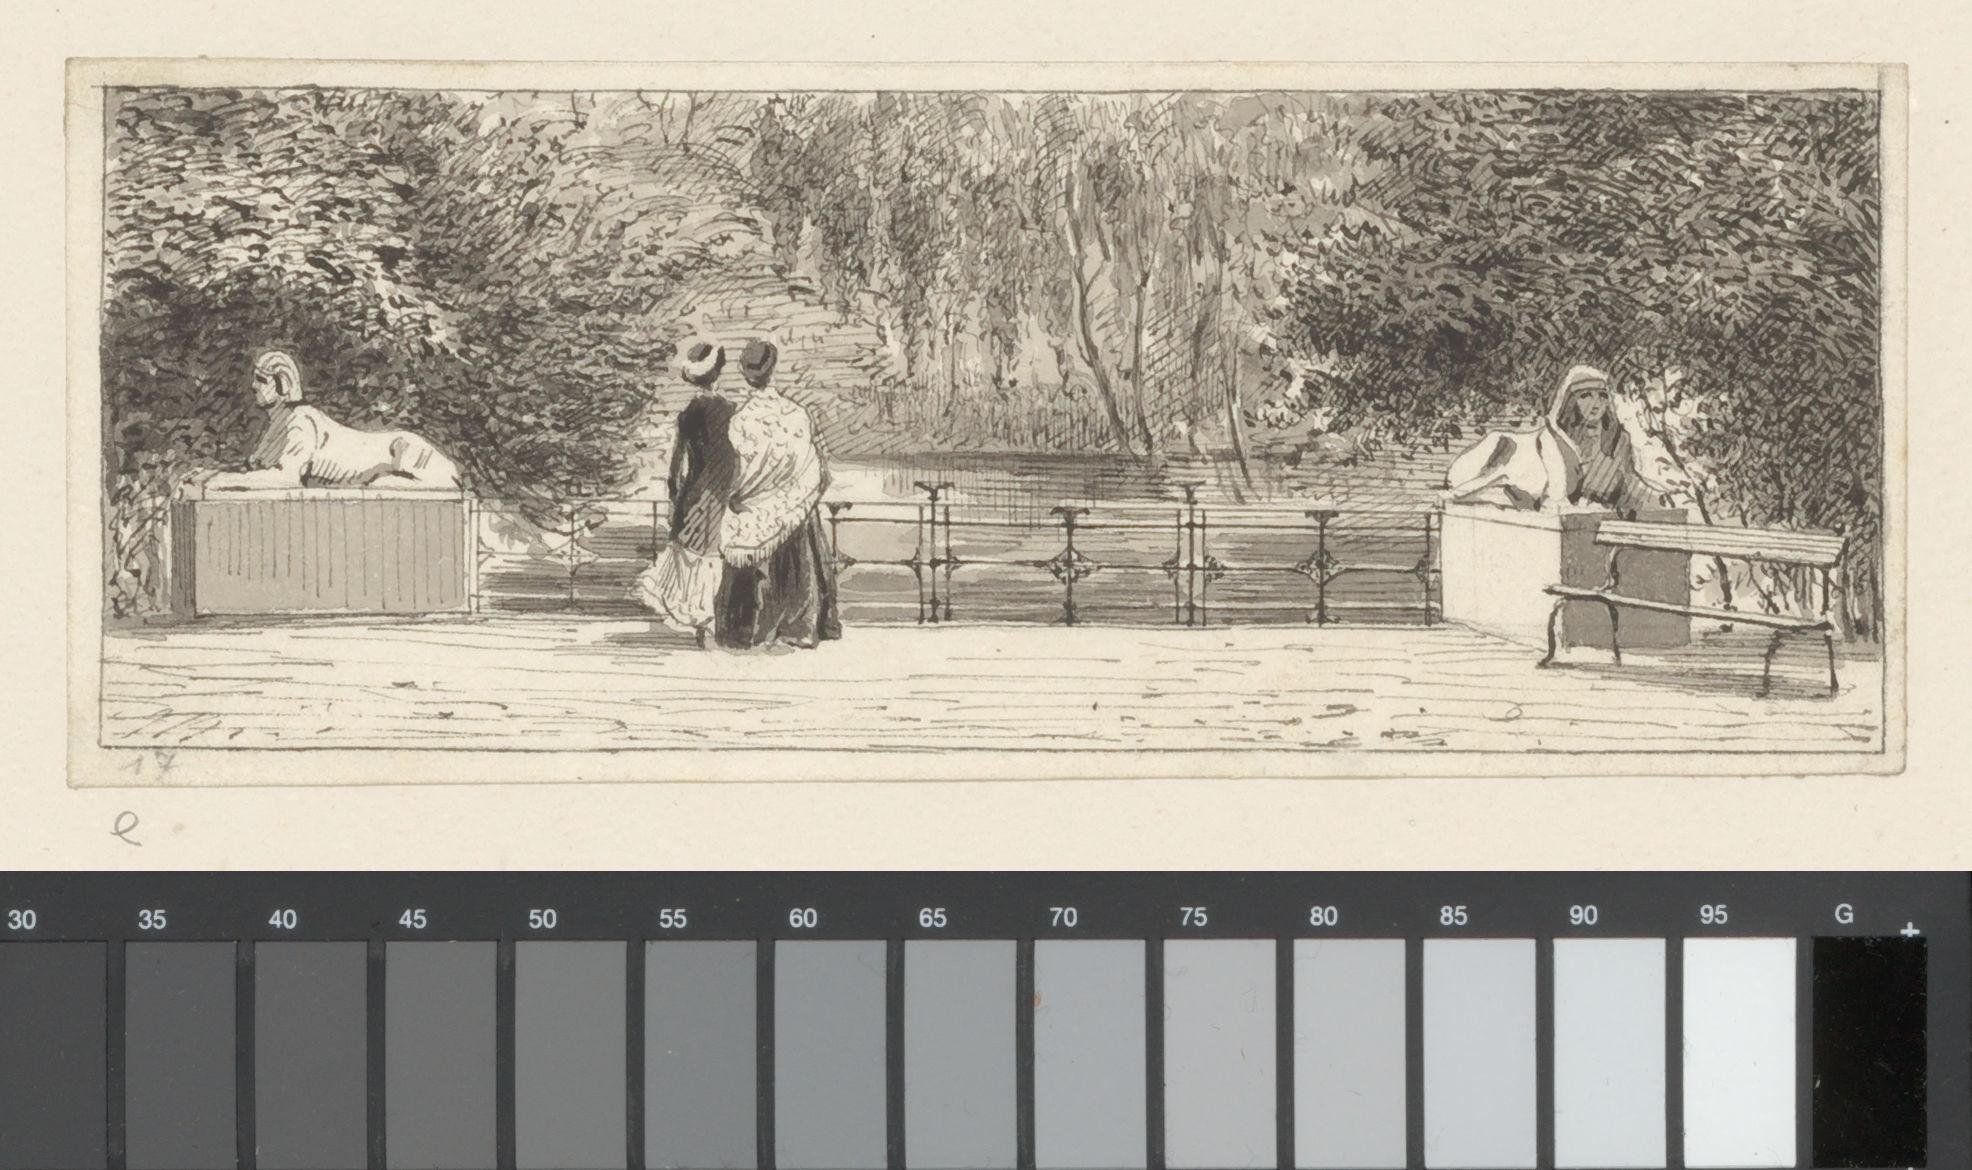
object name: drawing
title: Gezicht langs de grote vijver in Artis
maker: friedrich wilhelm wittig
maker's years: 1854-1912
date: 1880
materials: ink, paper, pencil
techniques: brush, pen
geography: amsterdam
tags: city-view in general; 'veduta', zoo (as place of recreation)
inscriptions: name: ‘In Artis Natura Magistra. / F. Wittig fecit.’, collector's mark: ‘51B / VDE 8.12.'86’, inscription: ‘Fr. Wittig / Erinnerungen (...) No 462 / 1088’, number: ‘77’, inscription: ‘Legaat Joh. M. Coffeng / 1966’, inscription: ‘zie het boek (...) 22 N. 689’